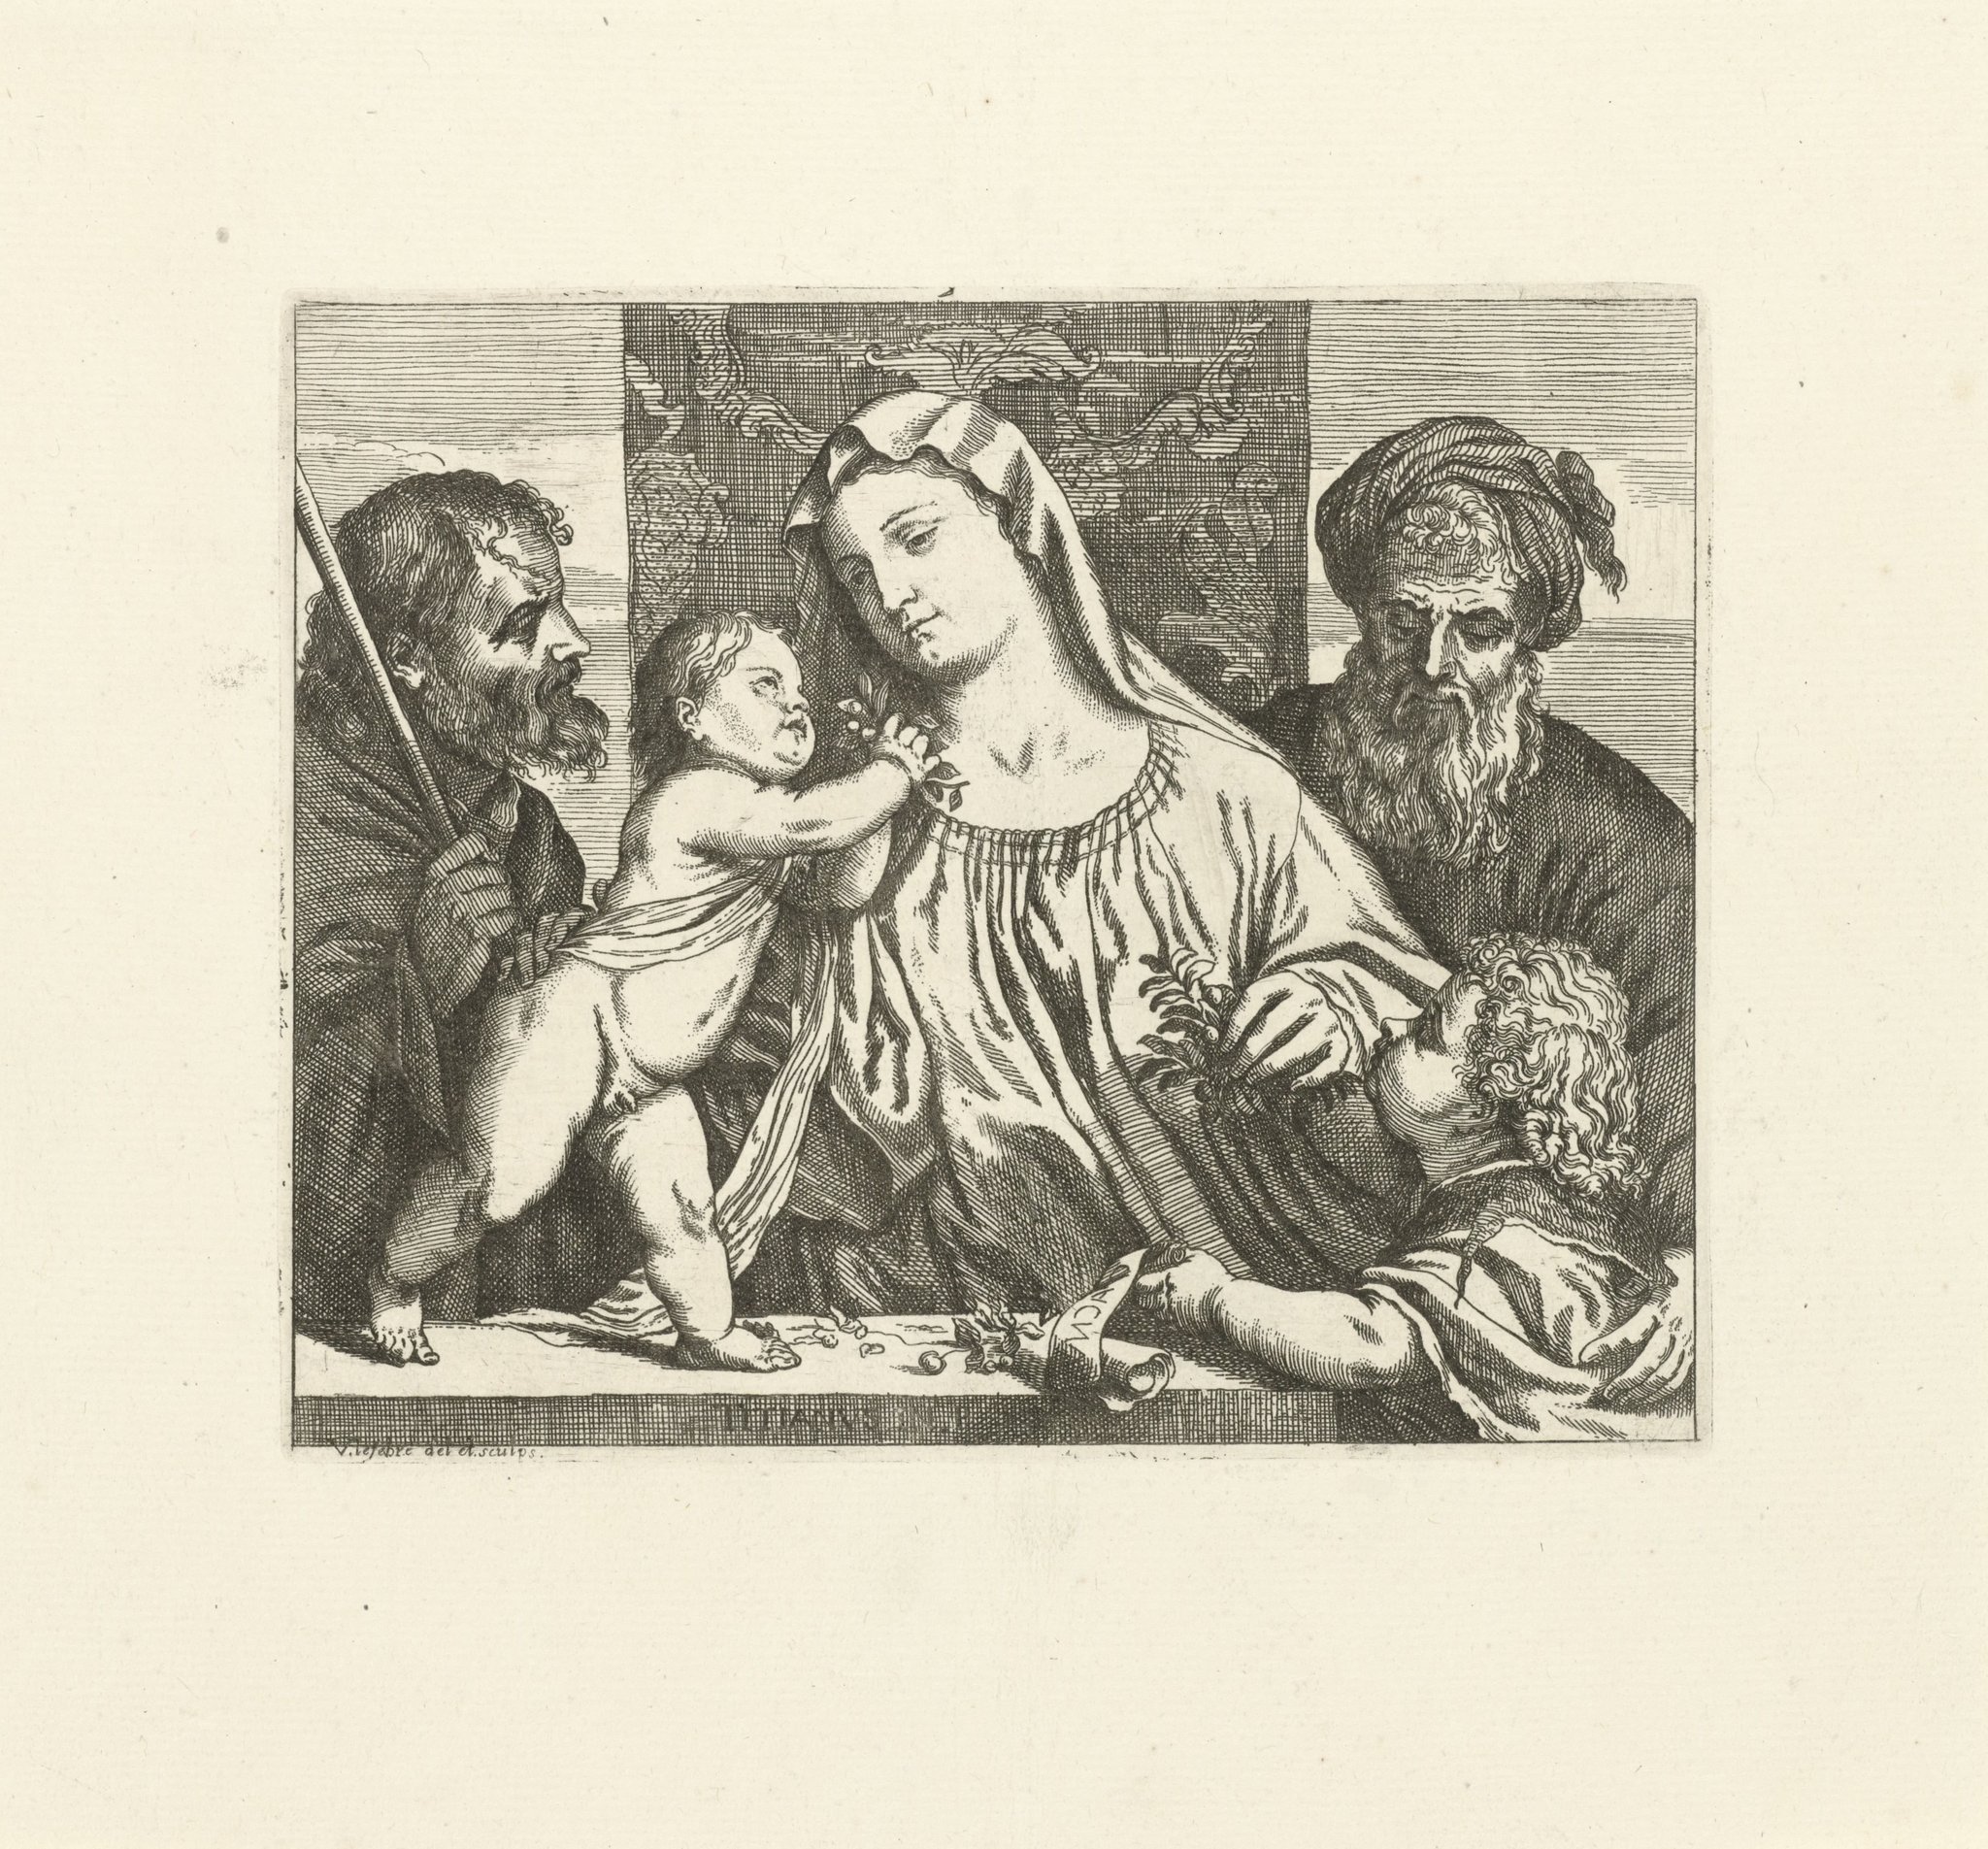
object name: print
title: Opera Selectiora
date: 1682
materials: paper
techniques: etching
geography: venice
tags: holy family with john the baptist (as child), christ-child holding something in his hand, e.g. apple, bird, cherries, crucifix, grapes, paper wind-mill ~ madonna-representations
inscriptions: collector's mark: Lugt 2228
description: Maria met het Christuskind, geflankeerd door Jozef (links) en Zacharias (rechts). Zowel Maria als Christus houden een takje kersen in de hand. Rechts kijkt de kleine Johannes de Doper toe. De prent maakt deel uit van een 53-delige serie prenten naar schilderijen van Titiaan en Veronese.